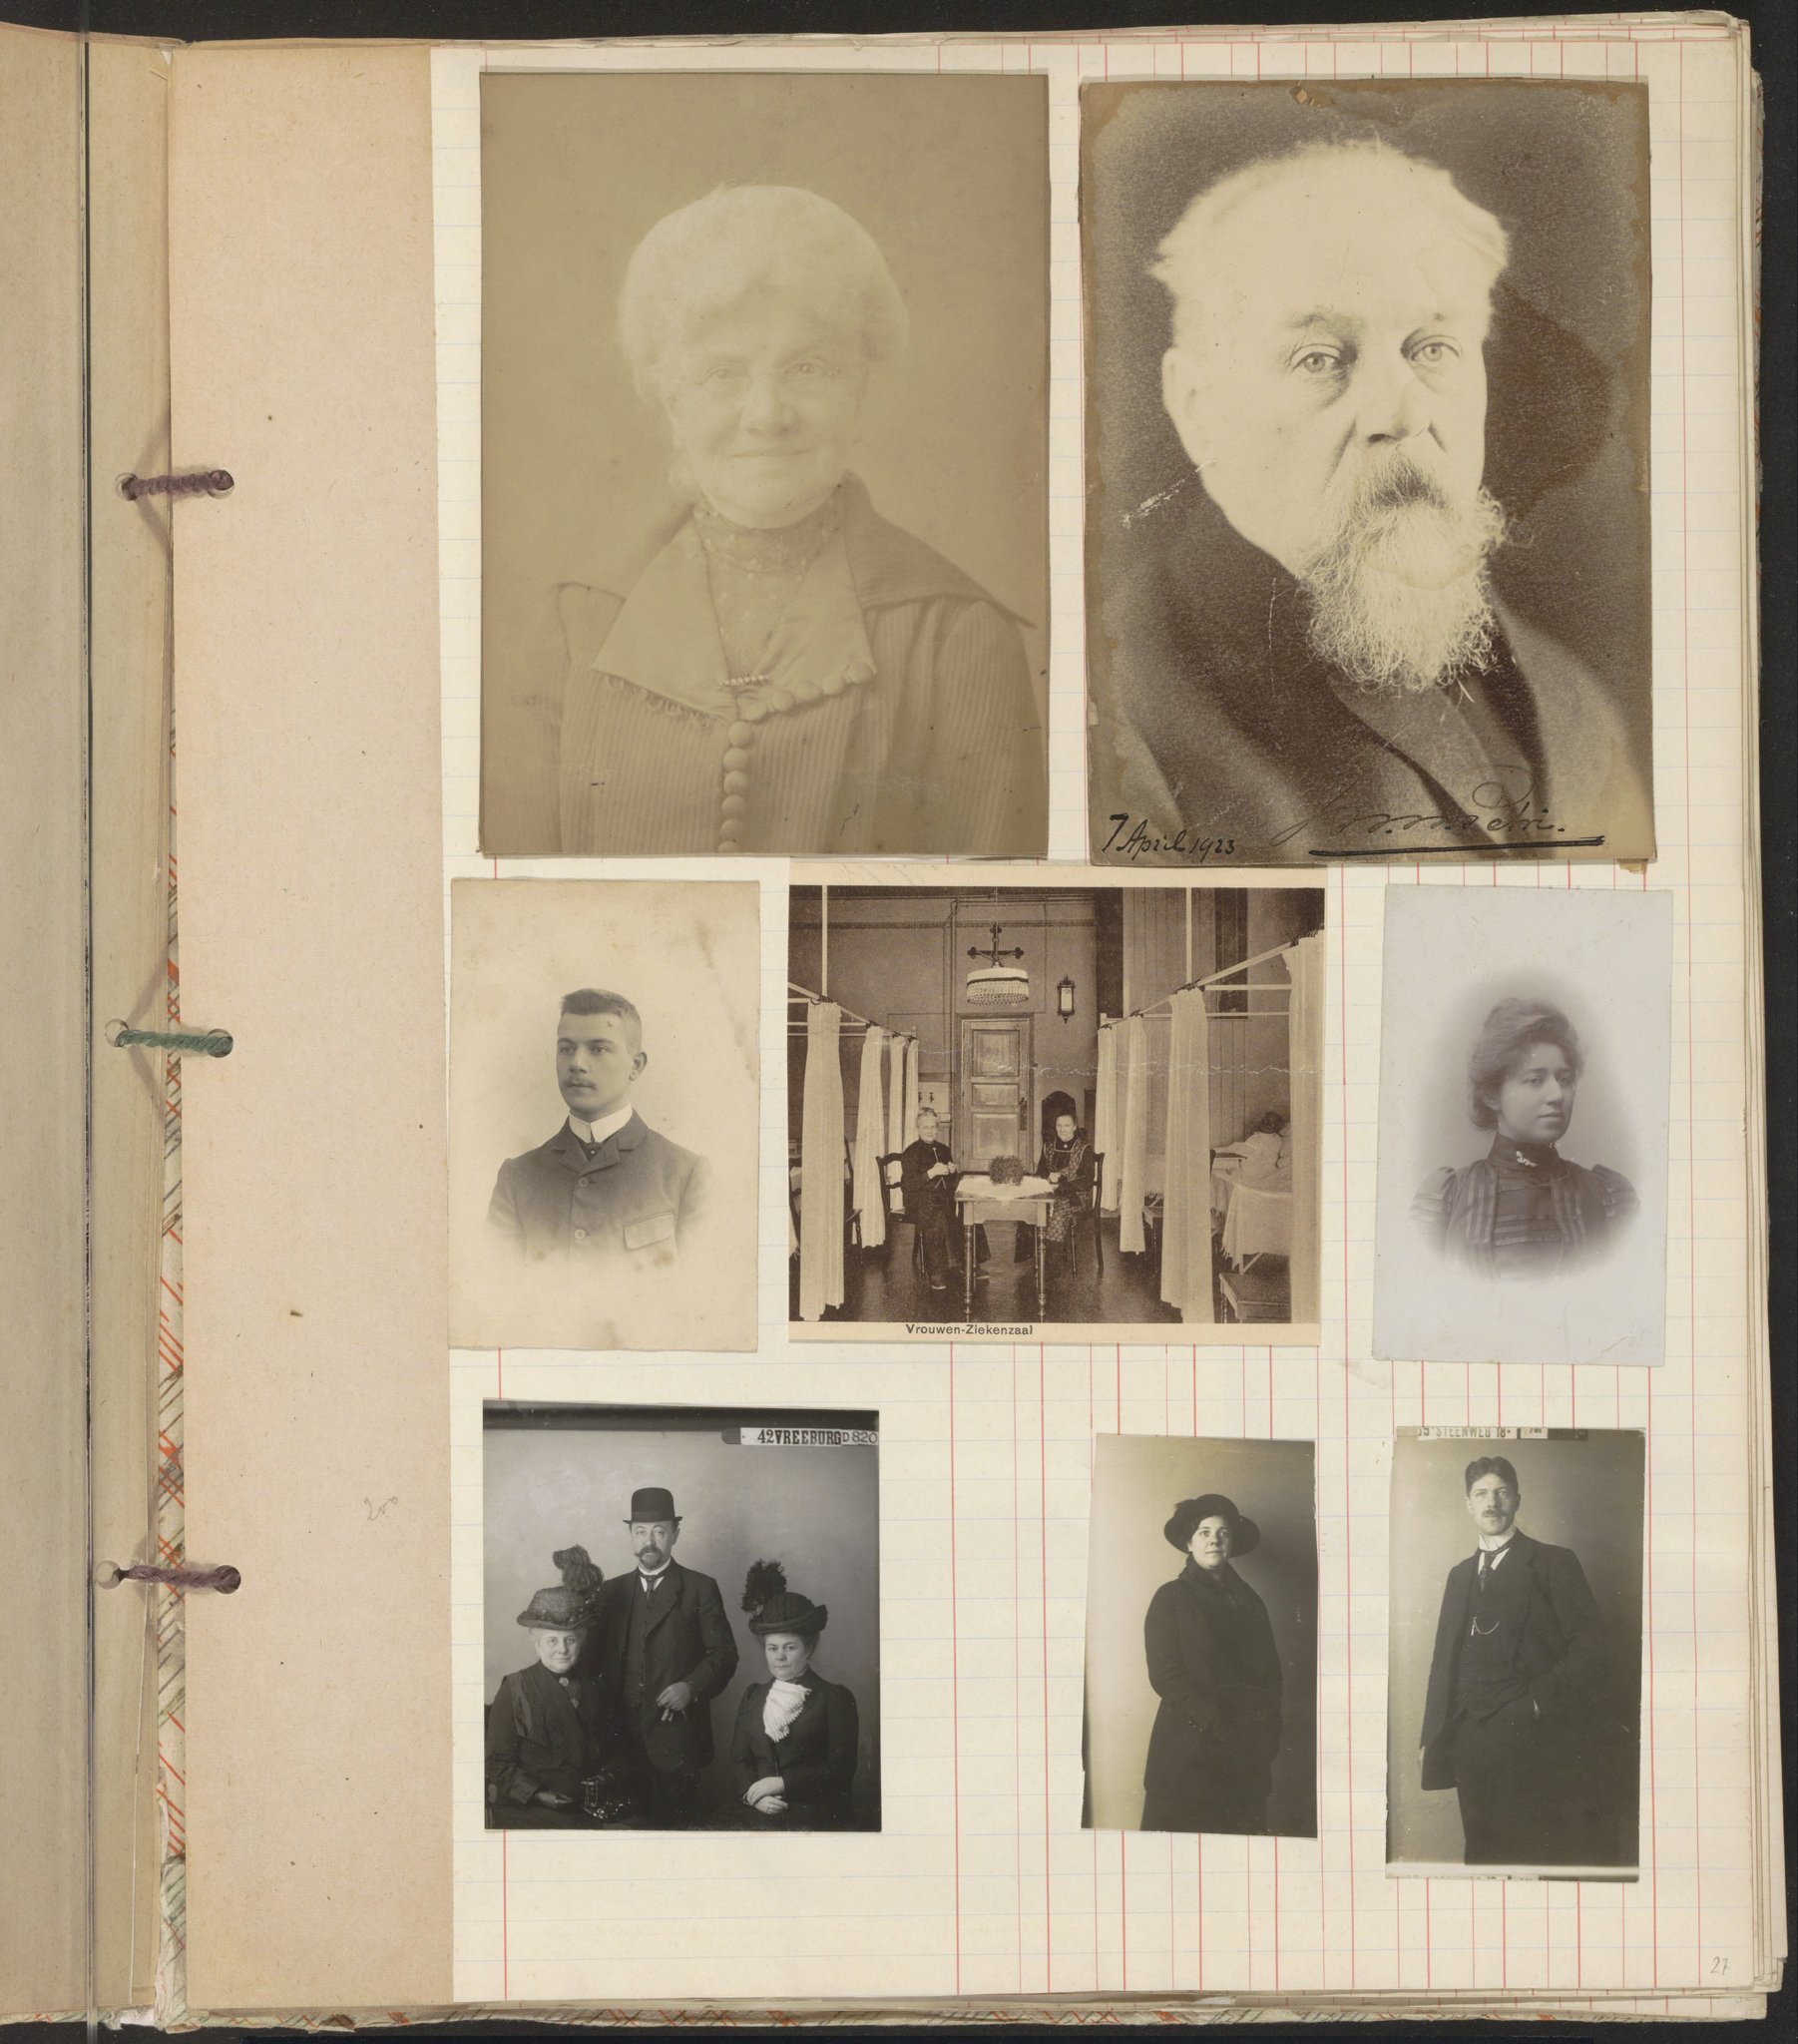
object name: snapshot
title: Portretten van onbekende personen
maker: Anonymous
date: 1910-1930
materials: paper, photographic support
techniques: photograph, gelatin silver print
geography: netherlands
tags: utrecht, adult woman, adult man, hospital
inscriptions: address: ‘Steenweg 18’, inscription: ‘1 april 1923 M. Petri’, number: ‘820’, number: ‘701’, address: ‘42 Vreeburg’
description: Albumblad met portretten van volwassenen waaronder dat van Martinus W. Petri. Ook een opname van twee vrouwen in een 'Vrouwen Ziekenzaal'. Onderdeel van Fotoalbum van de familie Petri.